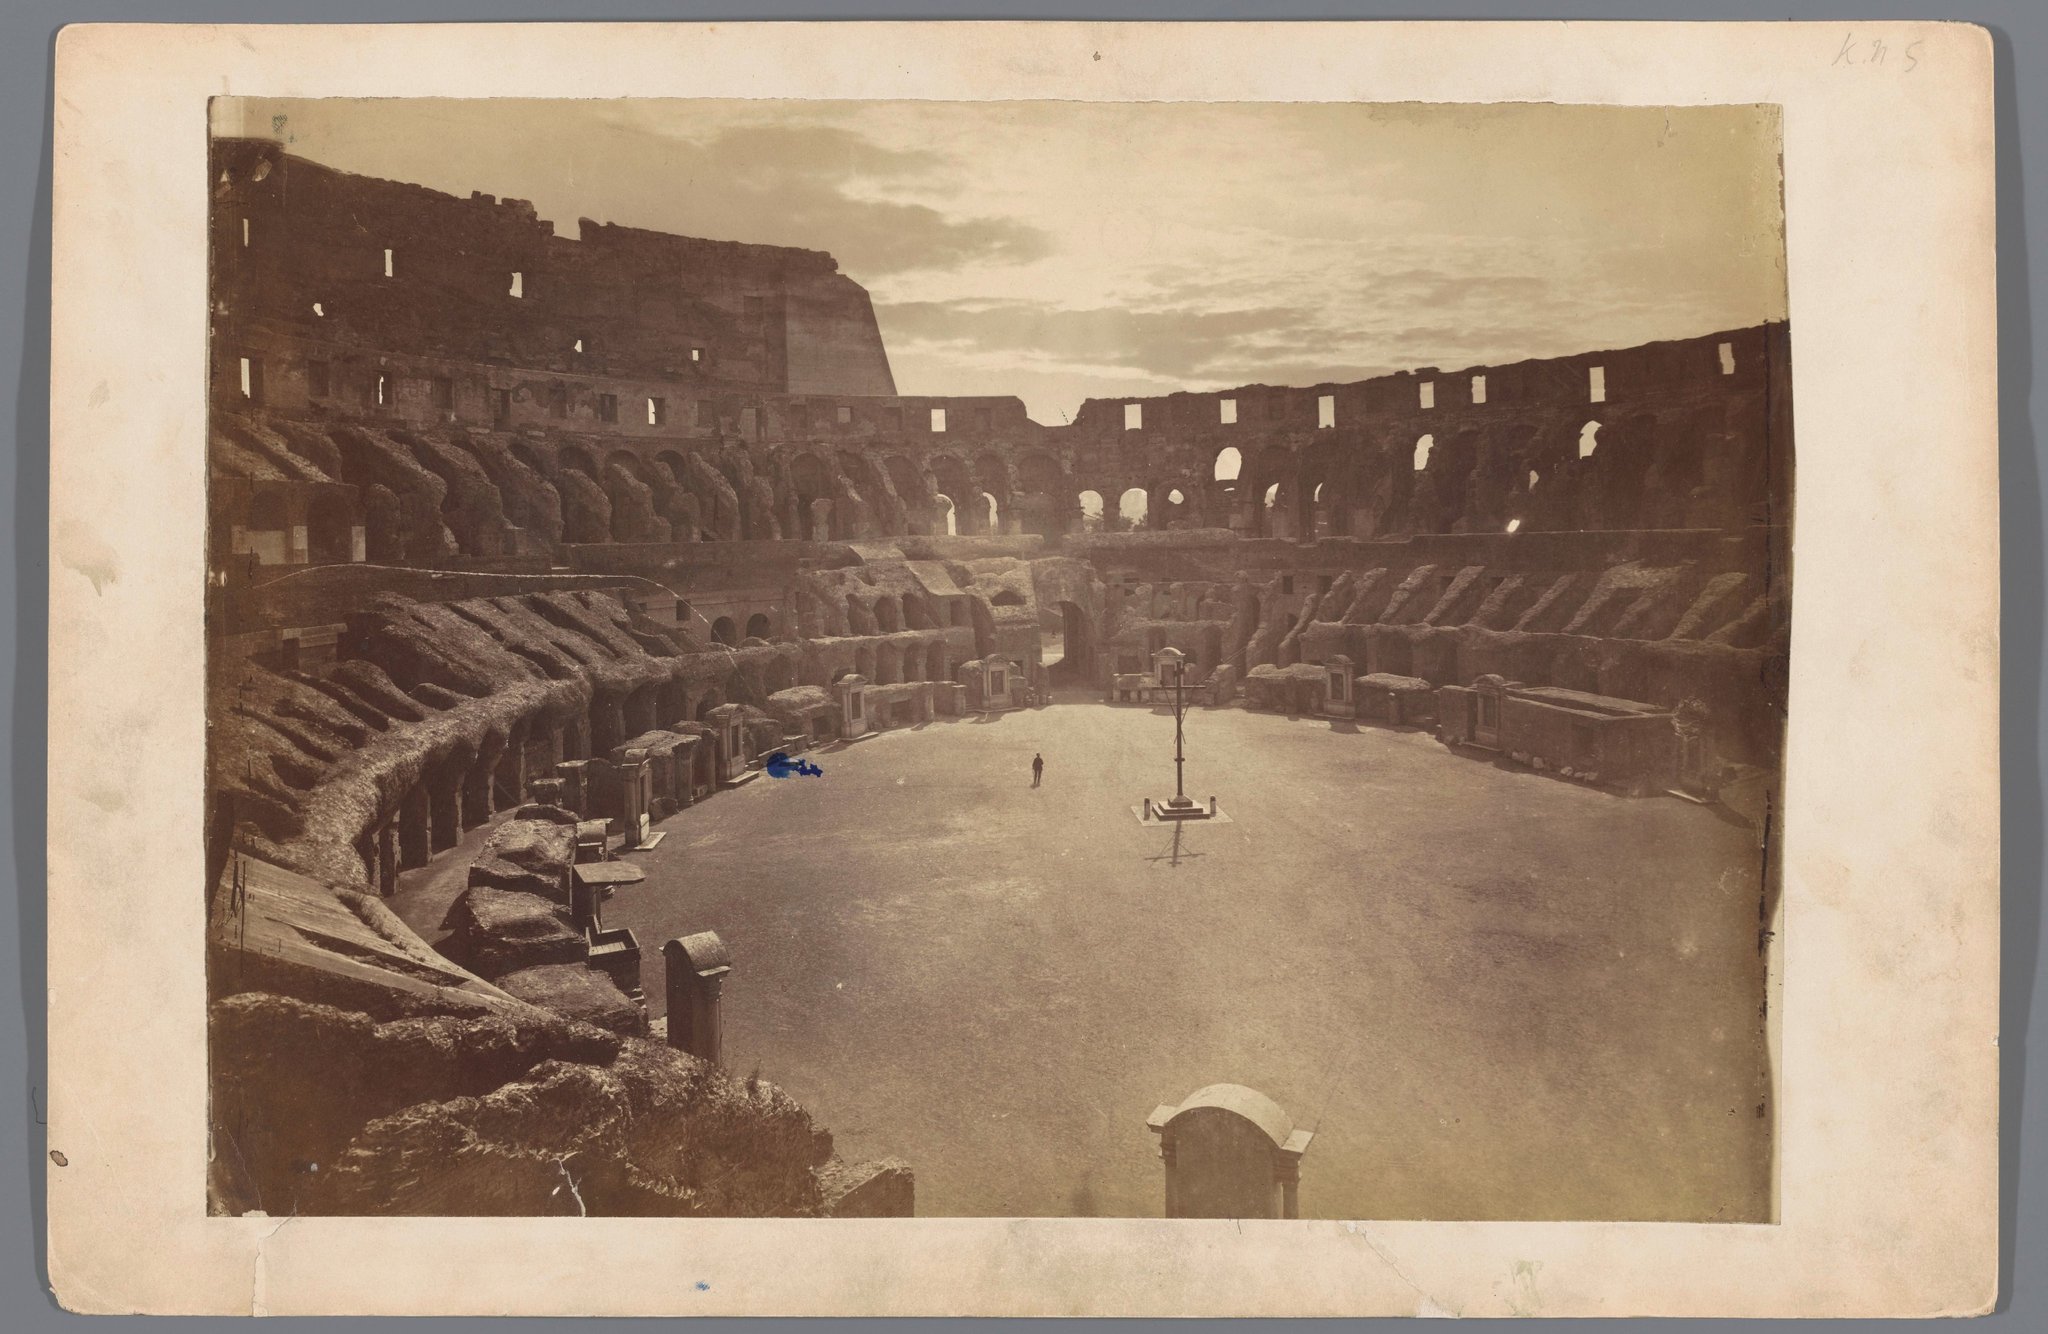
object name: photograph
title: Interieur van het Colosseum in Rome in avondlicht, Italië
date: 1857-1865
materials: cardboard, paper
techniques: albumen print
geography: rome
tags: amphitheatre, landscape with ruins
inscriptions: inscription: ‘R.k.d. techniek’, inscription: ‘(t) Altobelli & Molins’, inscription: ‘k.n.s.’, collector's mark: ‘RIJKS SCHOOL VOOR KUNSTNIJVERHEID/ GROEP’, inscription: ‘Rijks School voor Kunstnijverheid’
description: Gioacchino Altobelli gebruikte voor deze foto een combinatiedruk van twee negatieven om het dramatische effect van de wolkenlucht te bereiken. Hij is vermoedelijk geïnspireerd geraakt door Romantische dichters zoals Johann Wolfgang von Goethe en Lord Byron die plekken in Rome vaak bij maanlicht bezochten.